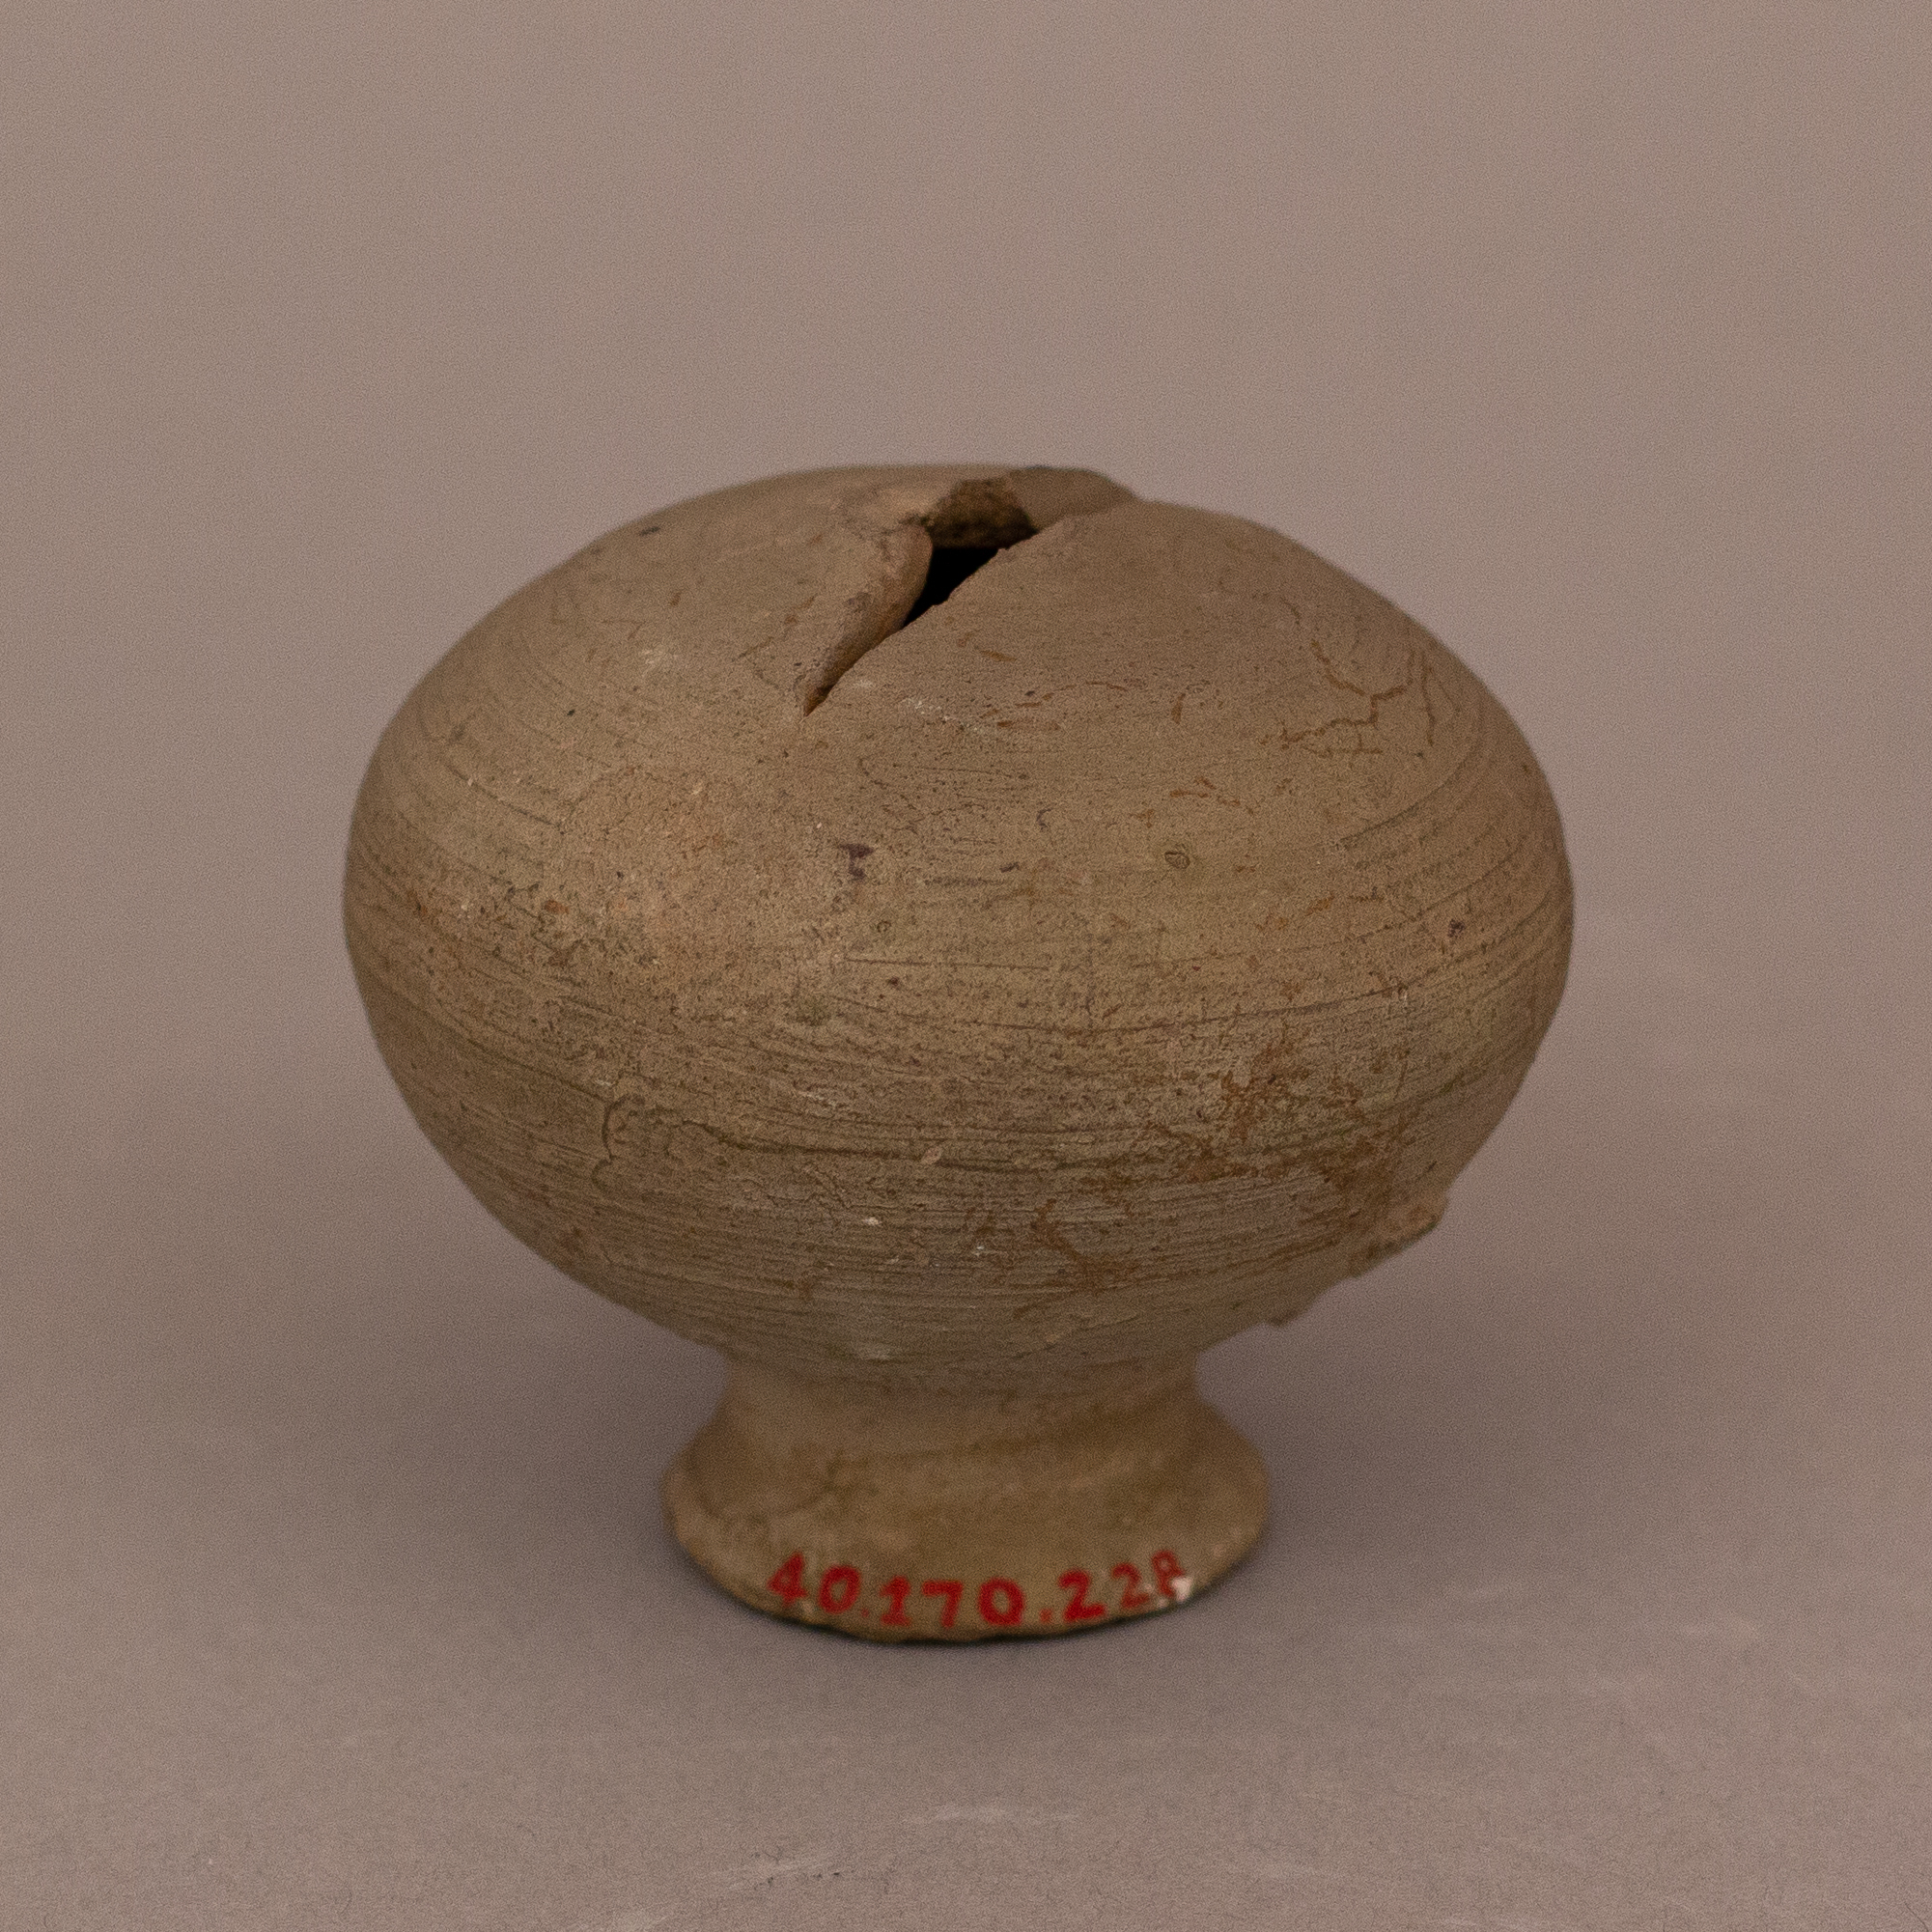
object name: box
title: Money Box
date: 801-1000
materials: earthenware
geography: iran